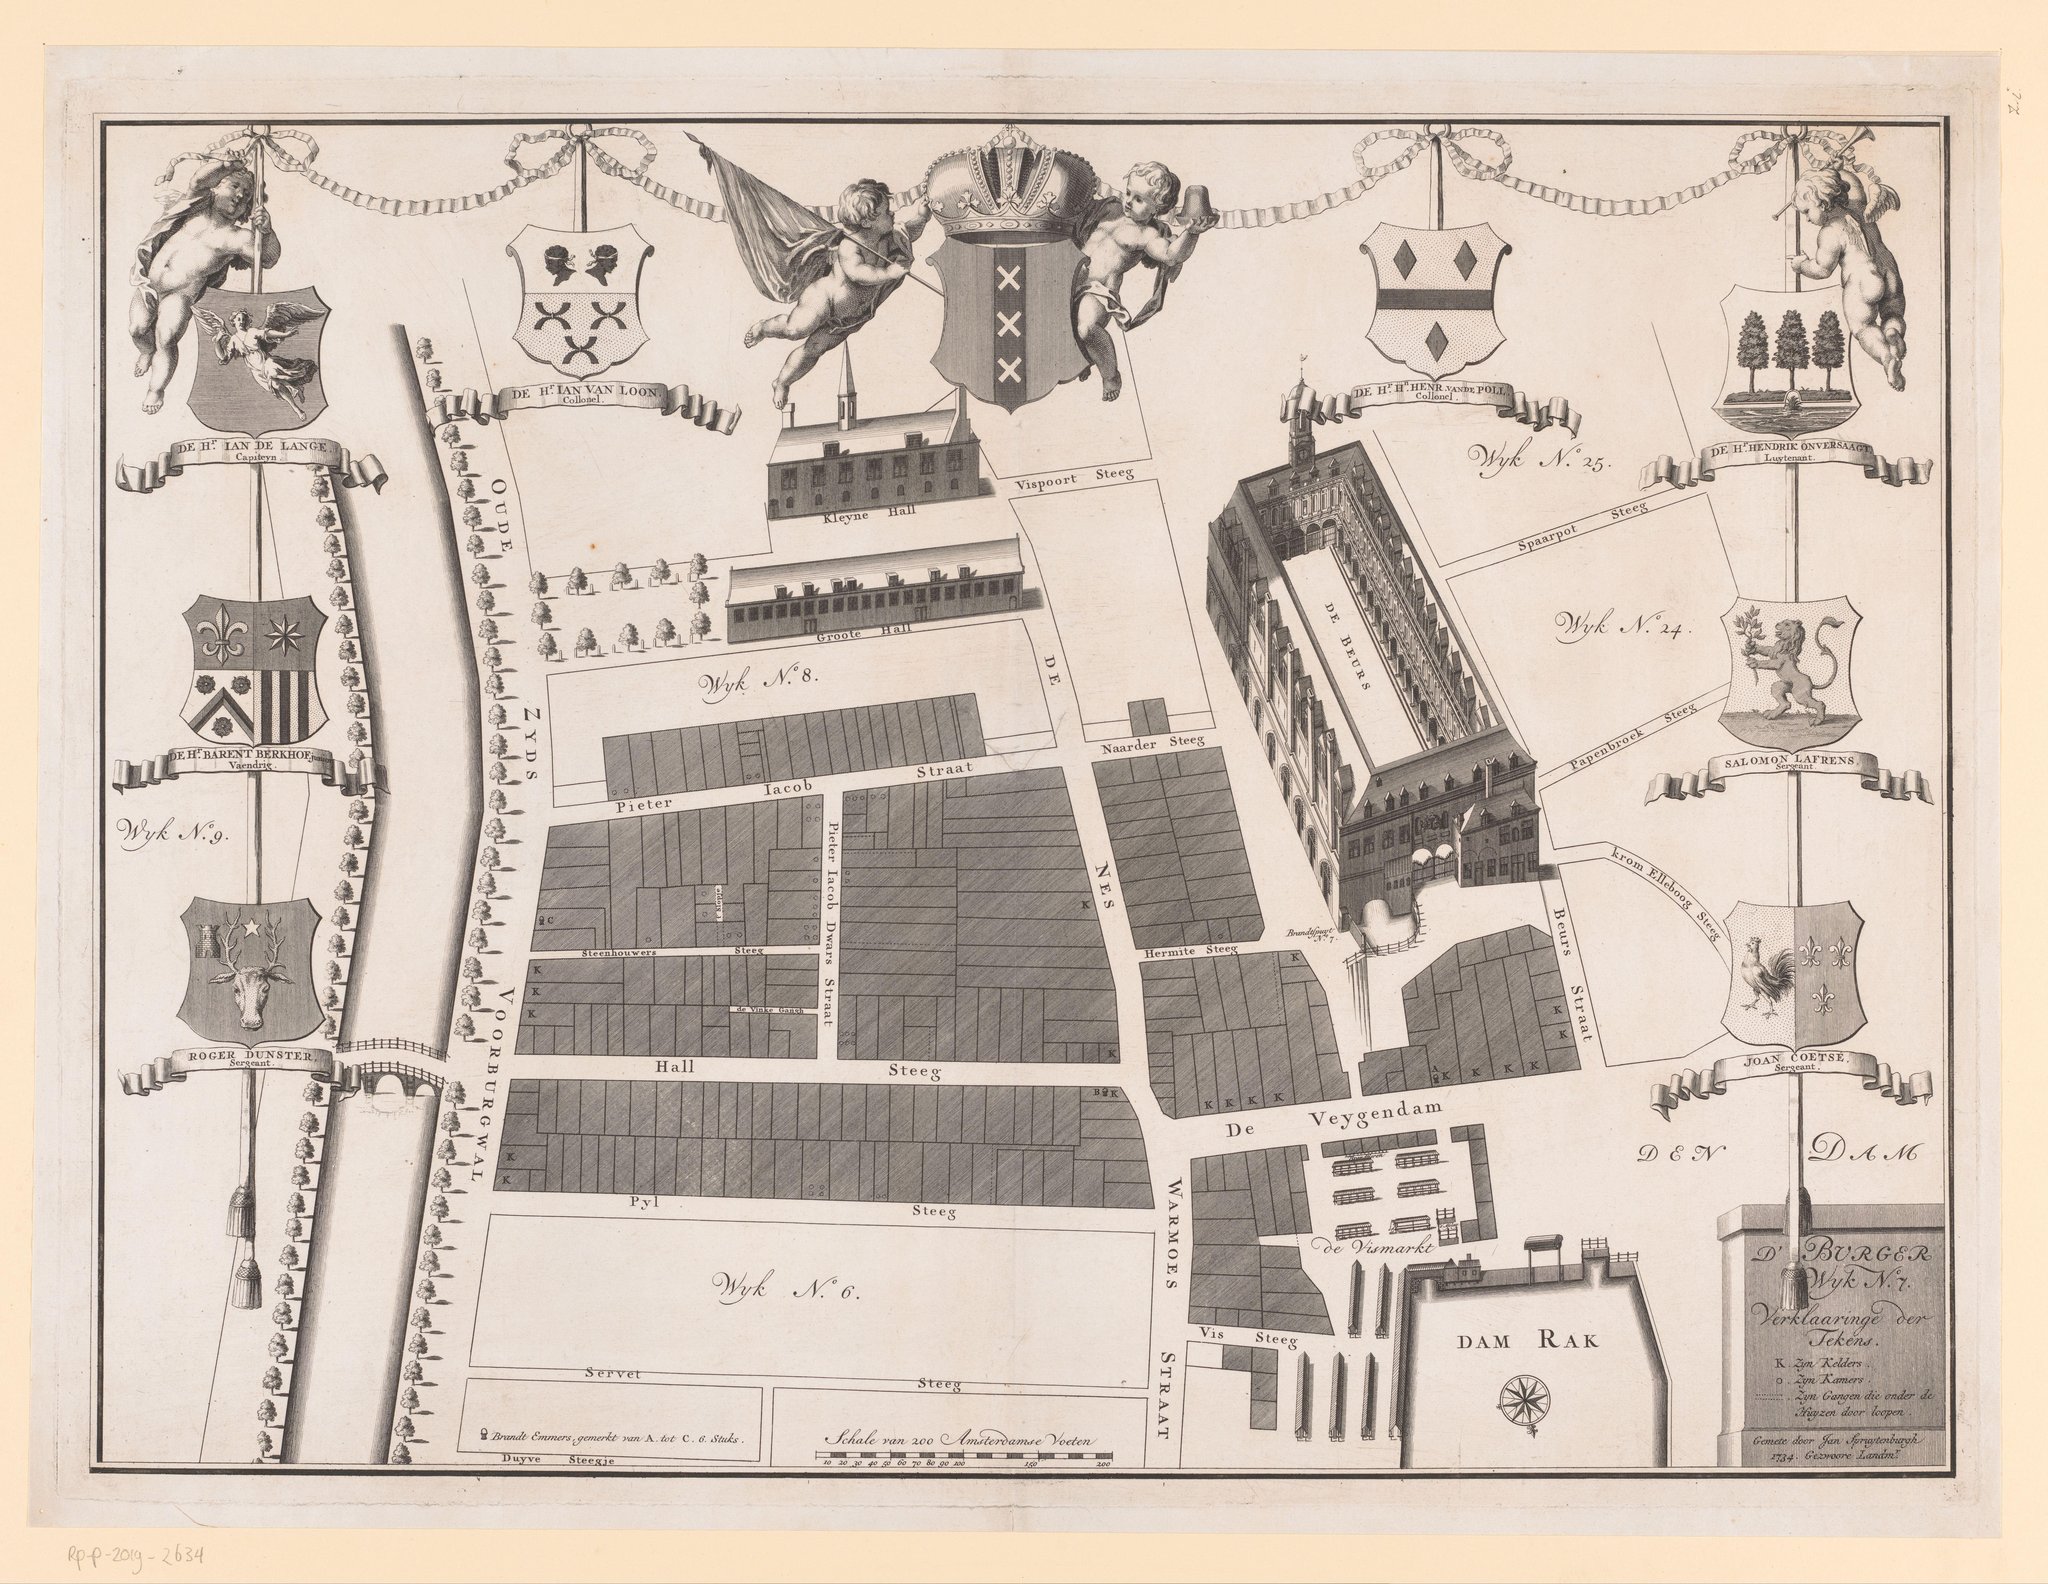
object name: print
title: Plattegrond van burgerwijk VII te Amsterdam, onder leiding van kapitein Jan de Lange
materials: paper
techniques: engraving, etching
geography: amsterdam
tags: coat of arms (as symbol of the state, etc.) (+ city; municipal), stock exchange, stock-market, maps of cities, armorial bearing, heraldry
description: Rondom de plattegrond de namen en familiewapens van de burgerwachten.